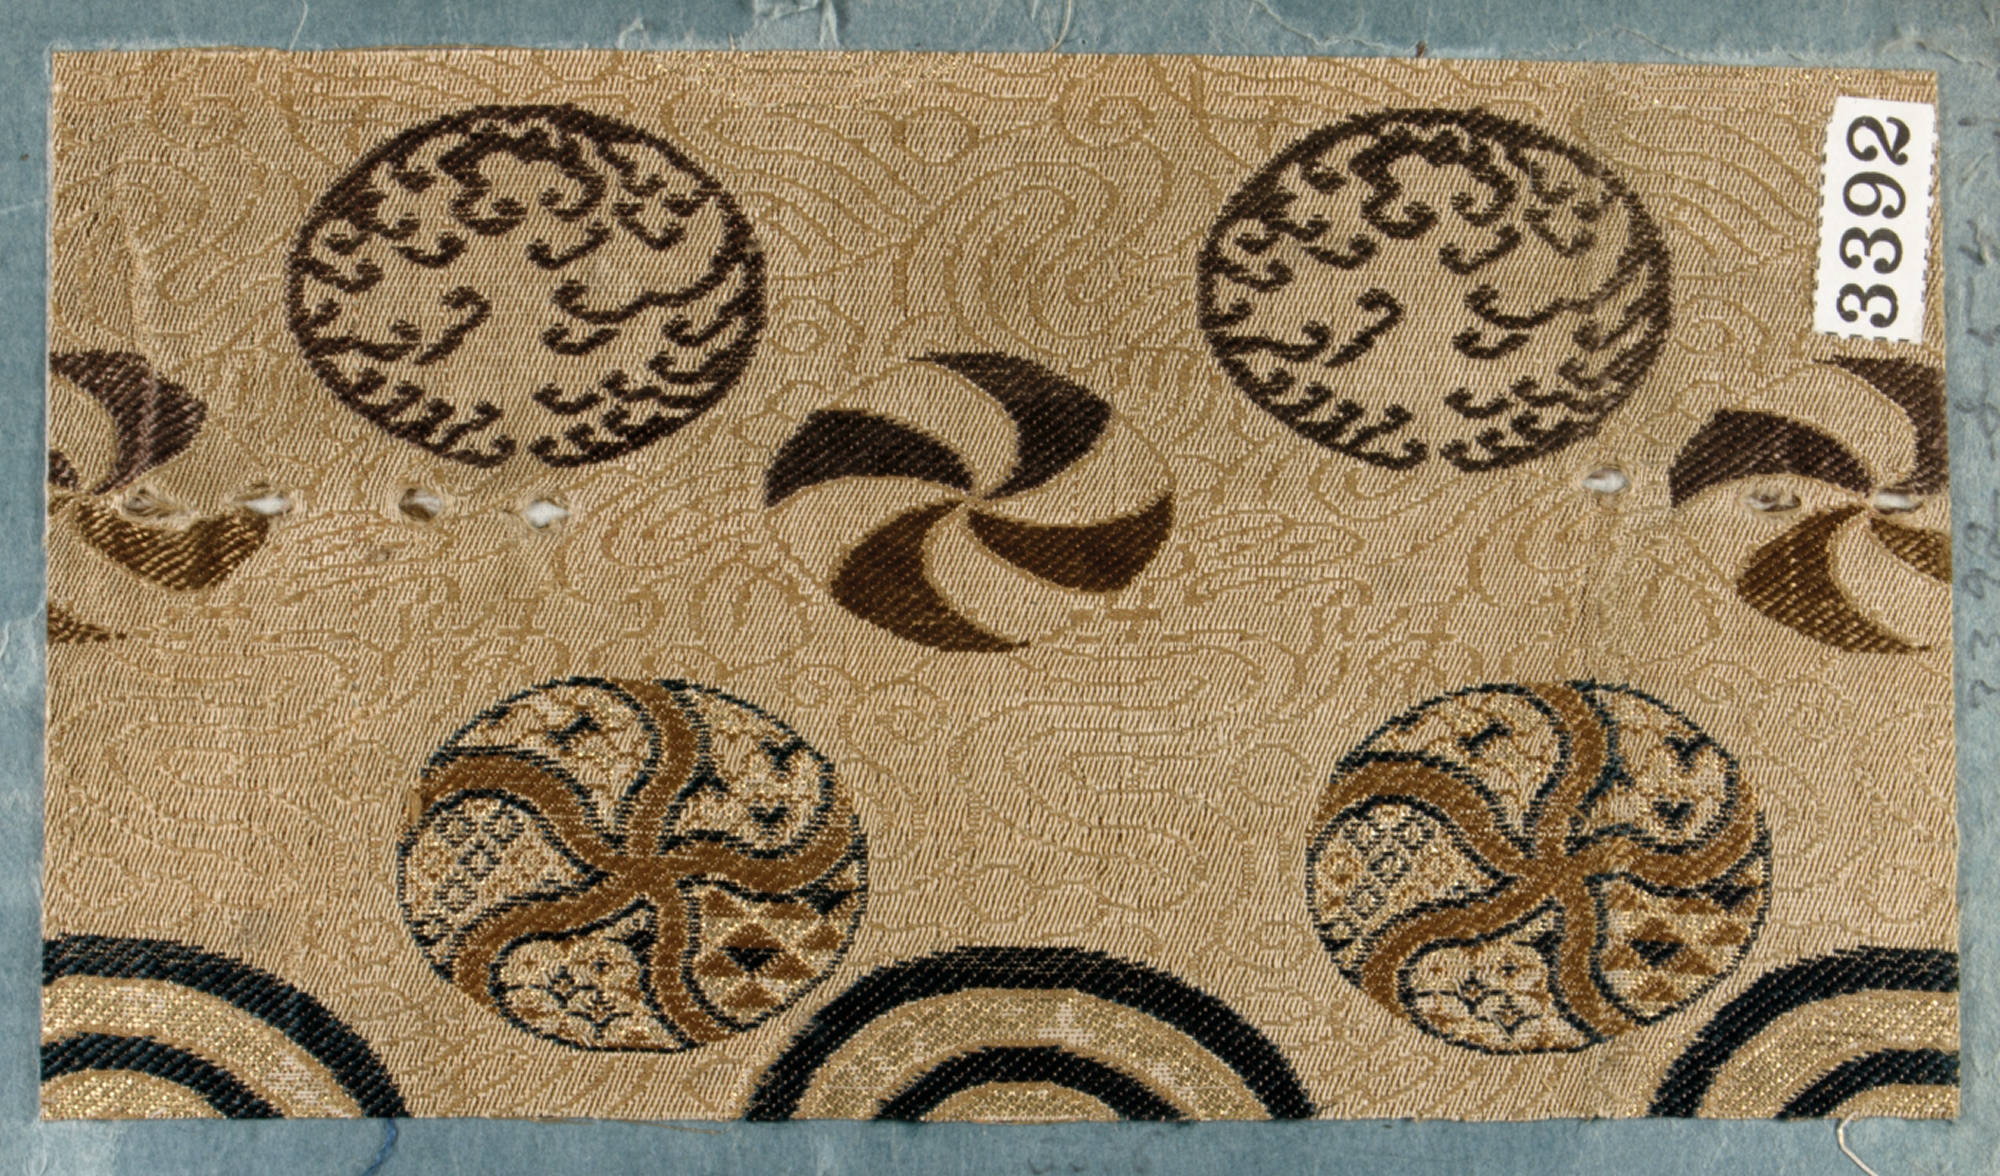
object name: textile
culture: japanese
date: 1801-1900